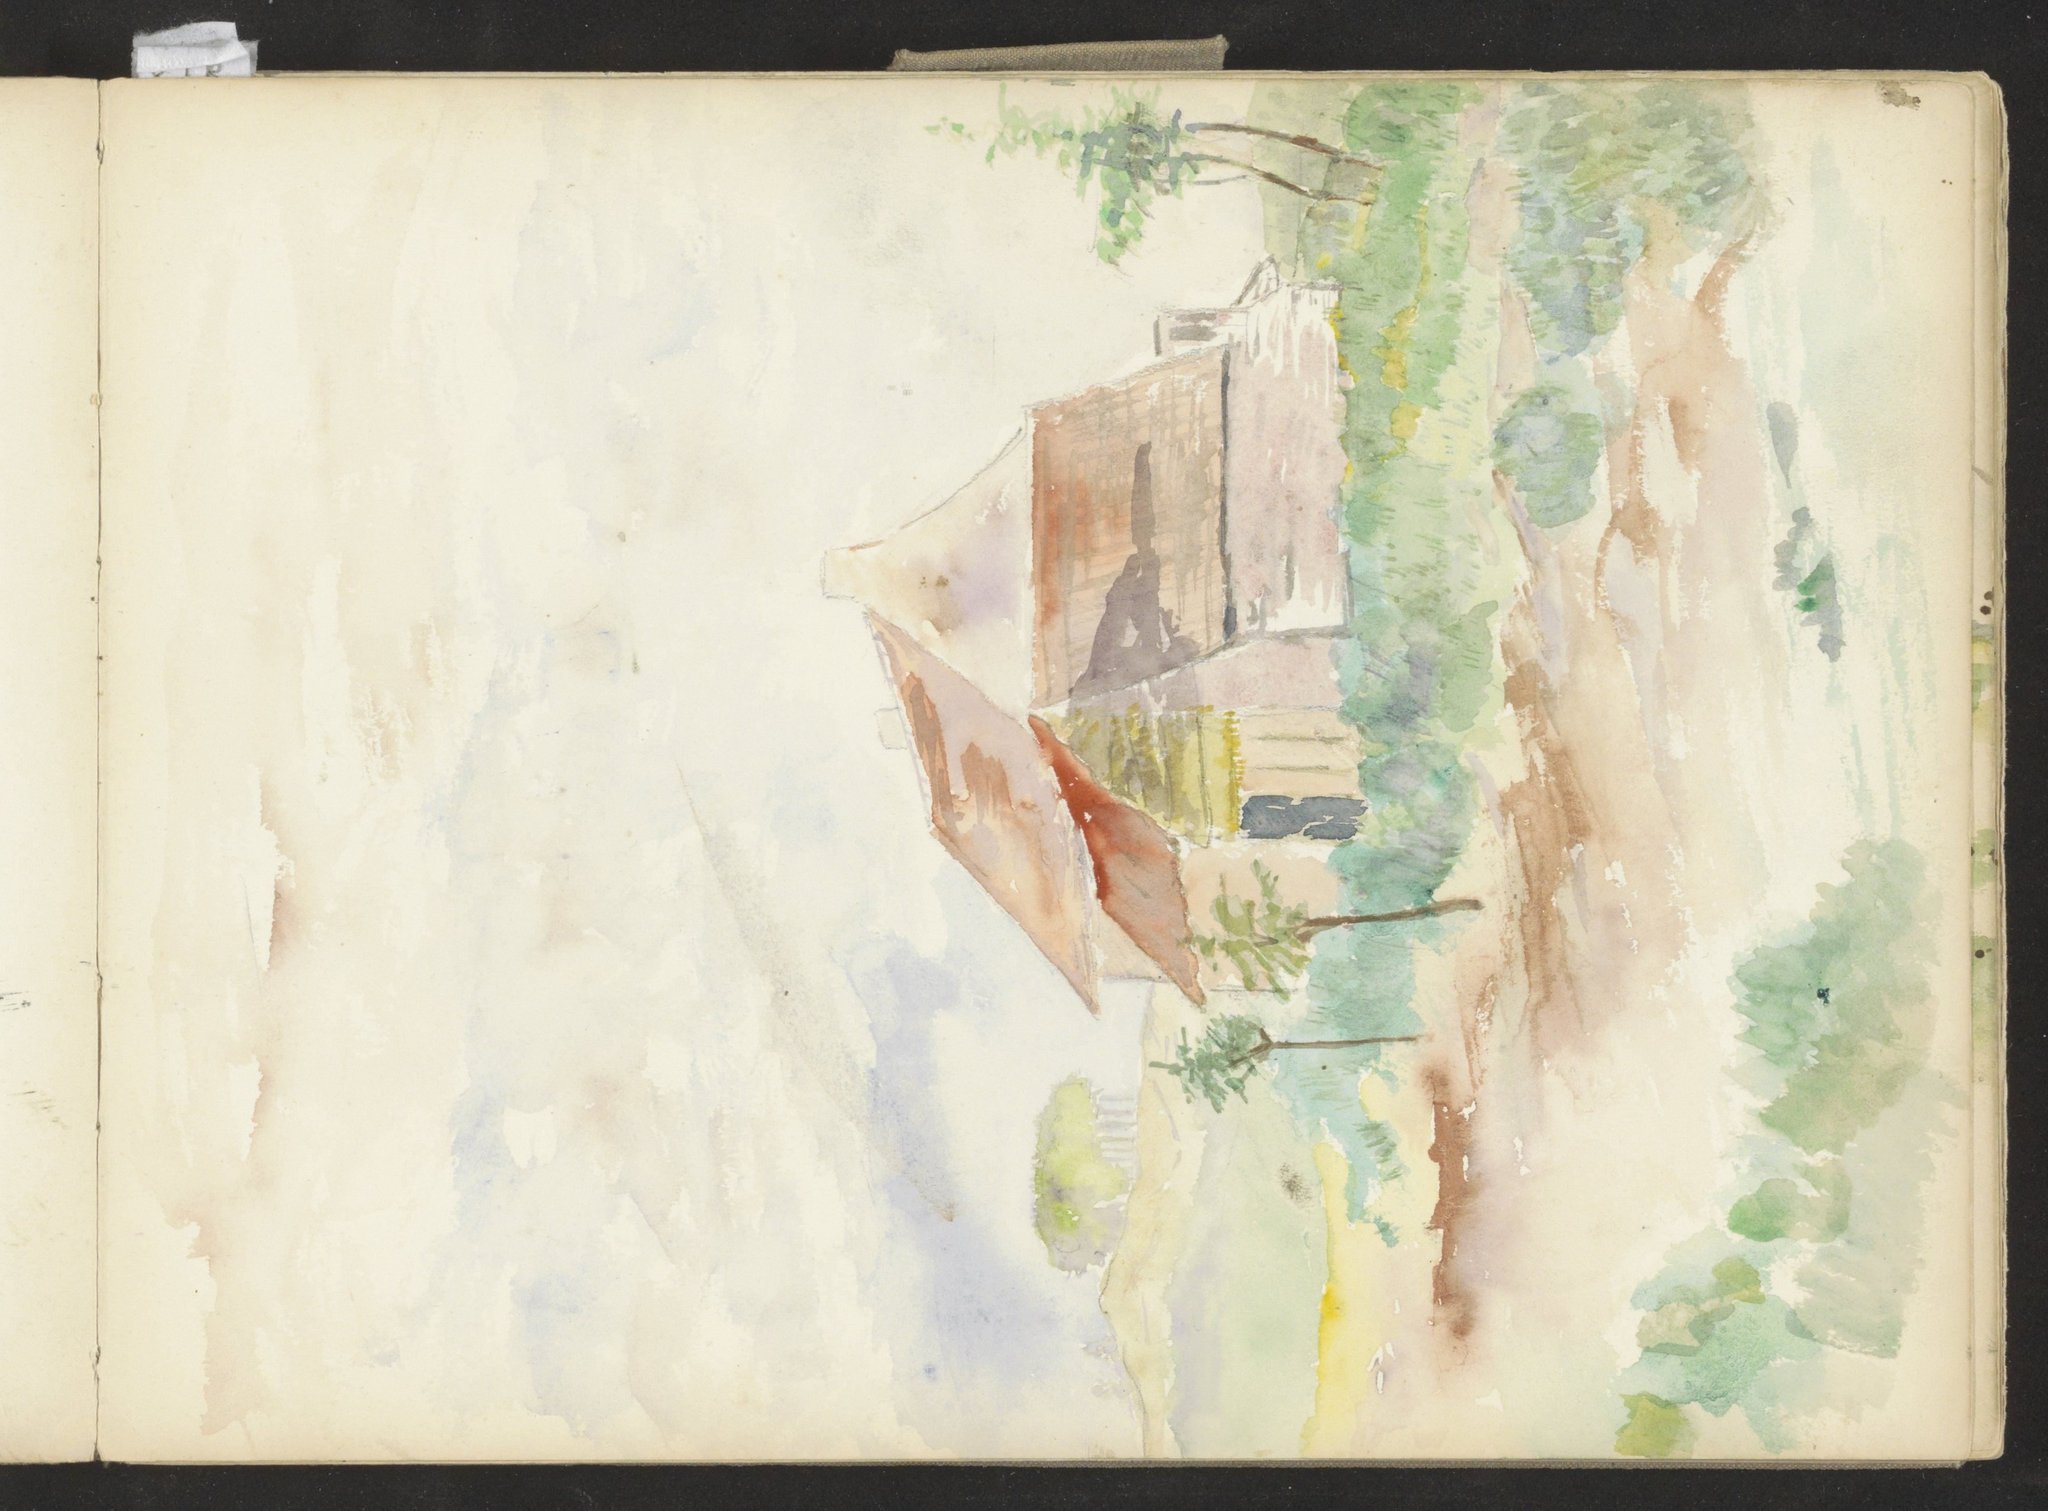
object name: sketchbook leaf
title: Boerderij aan een weg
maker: jonkheer johannes ludovicus paulus bosch van drakestein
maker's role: draughtsman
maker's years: 1865-1929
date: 1913-1916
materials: paper, pencil, watercolor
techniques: brush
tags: farm or solitary house in landscape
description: Blad 3 recto uit een schetsboek met 47 bladen.